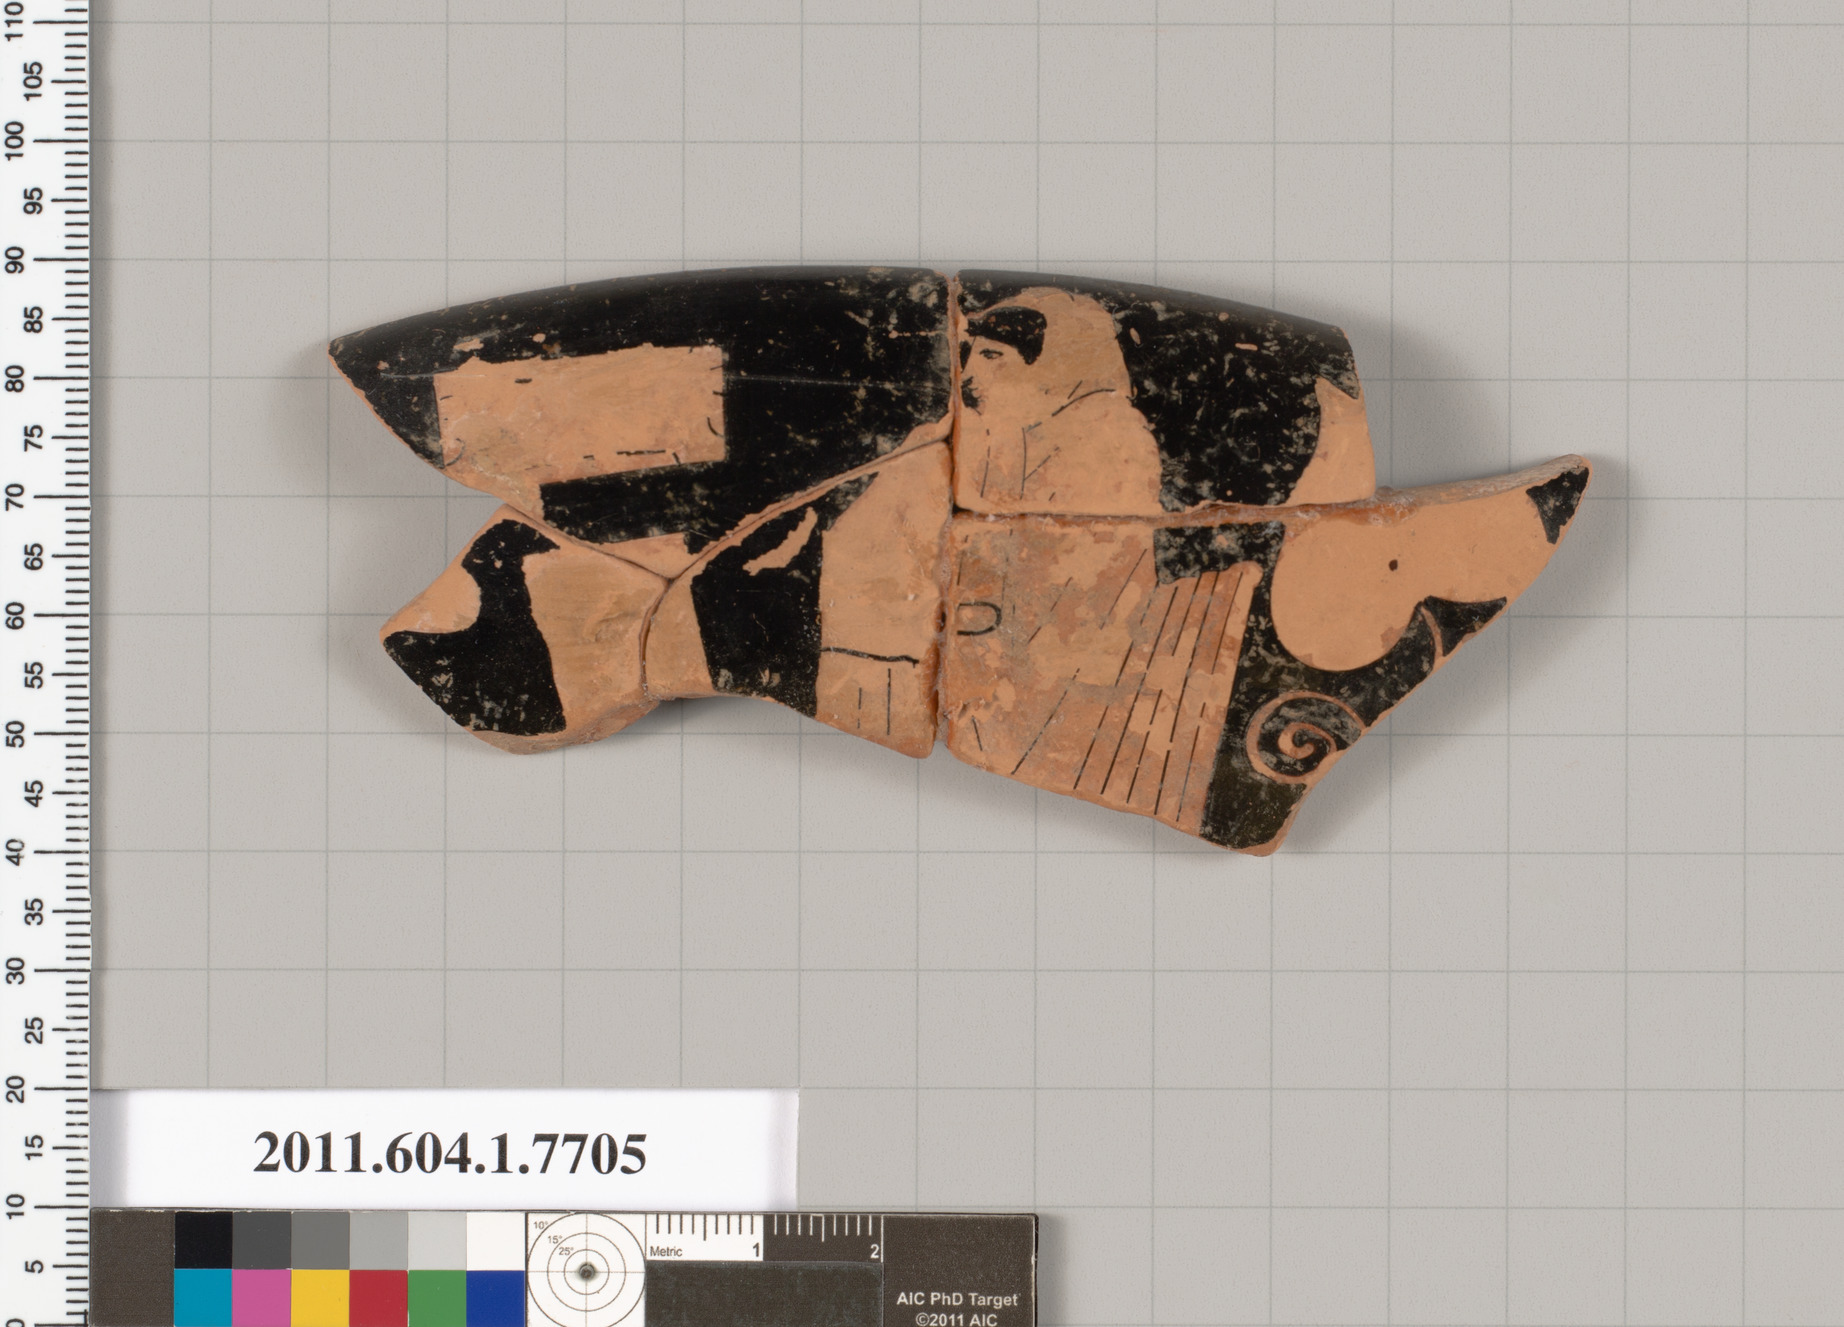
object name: kylix fragment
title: Terracotta fragment of a kylix (drinking cup)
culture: greek, attic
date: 460-450 BCE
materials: terracotta